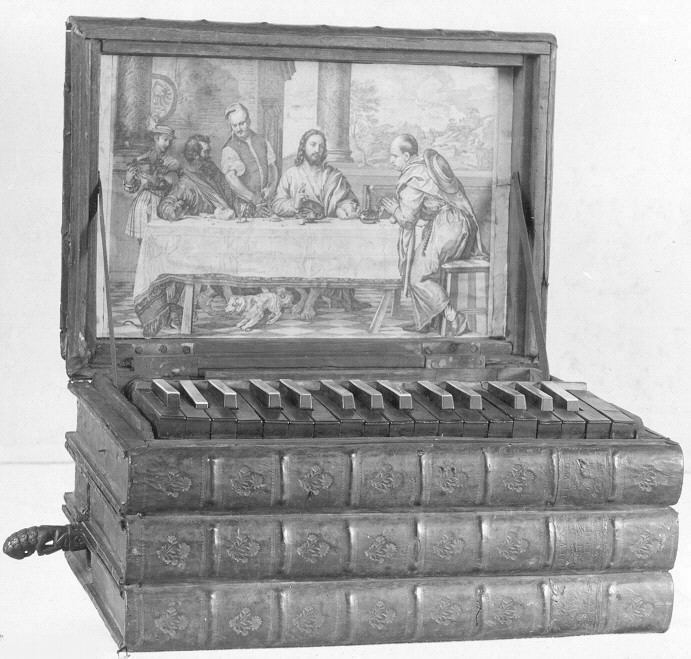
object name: book harmonium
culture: french or german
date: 1801-1900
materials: wood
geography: france or germany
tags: books,men